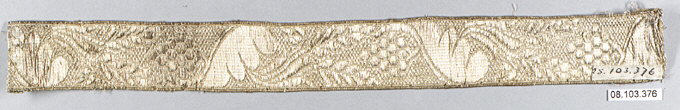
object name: galloon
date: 1601-1800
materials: metal thread